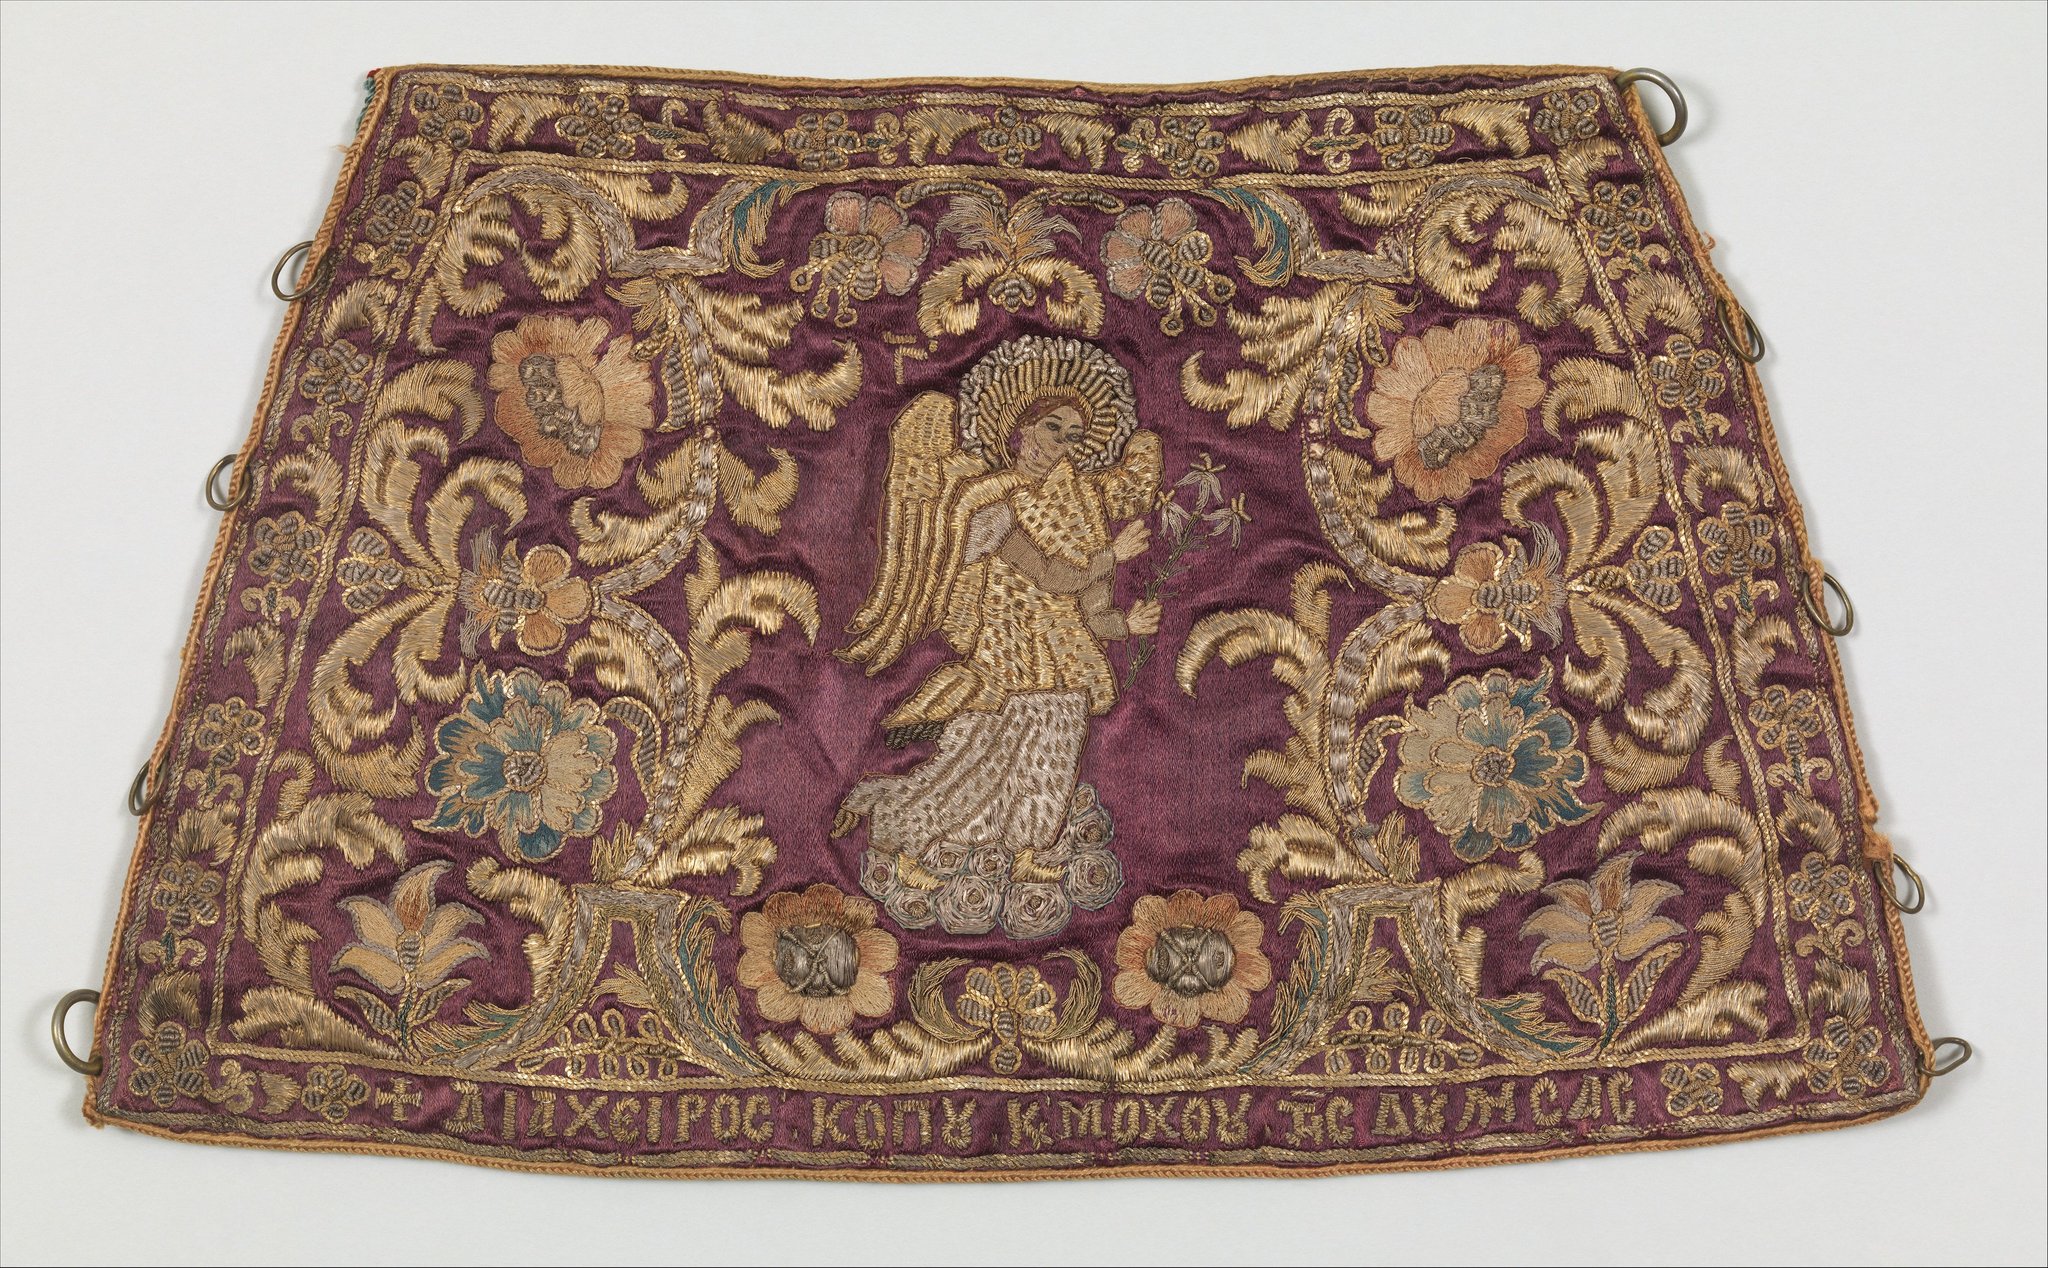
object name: cuff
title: Liturgical cuff (Epimanikion)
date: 1740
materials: metal, metal thread, silk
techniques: embroidery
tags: archangel gabriel,annunciation